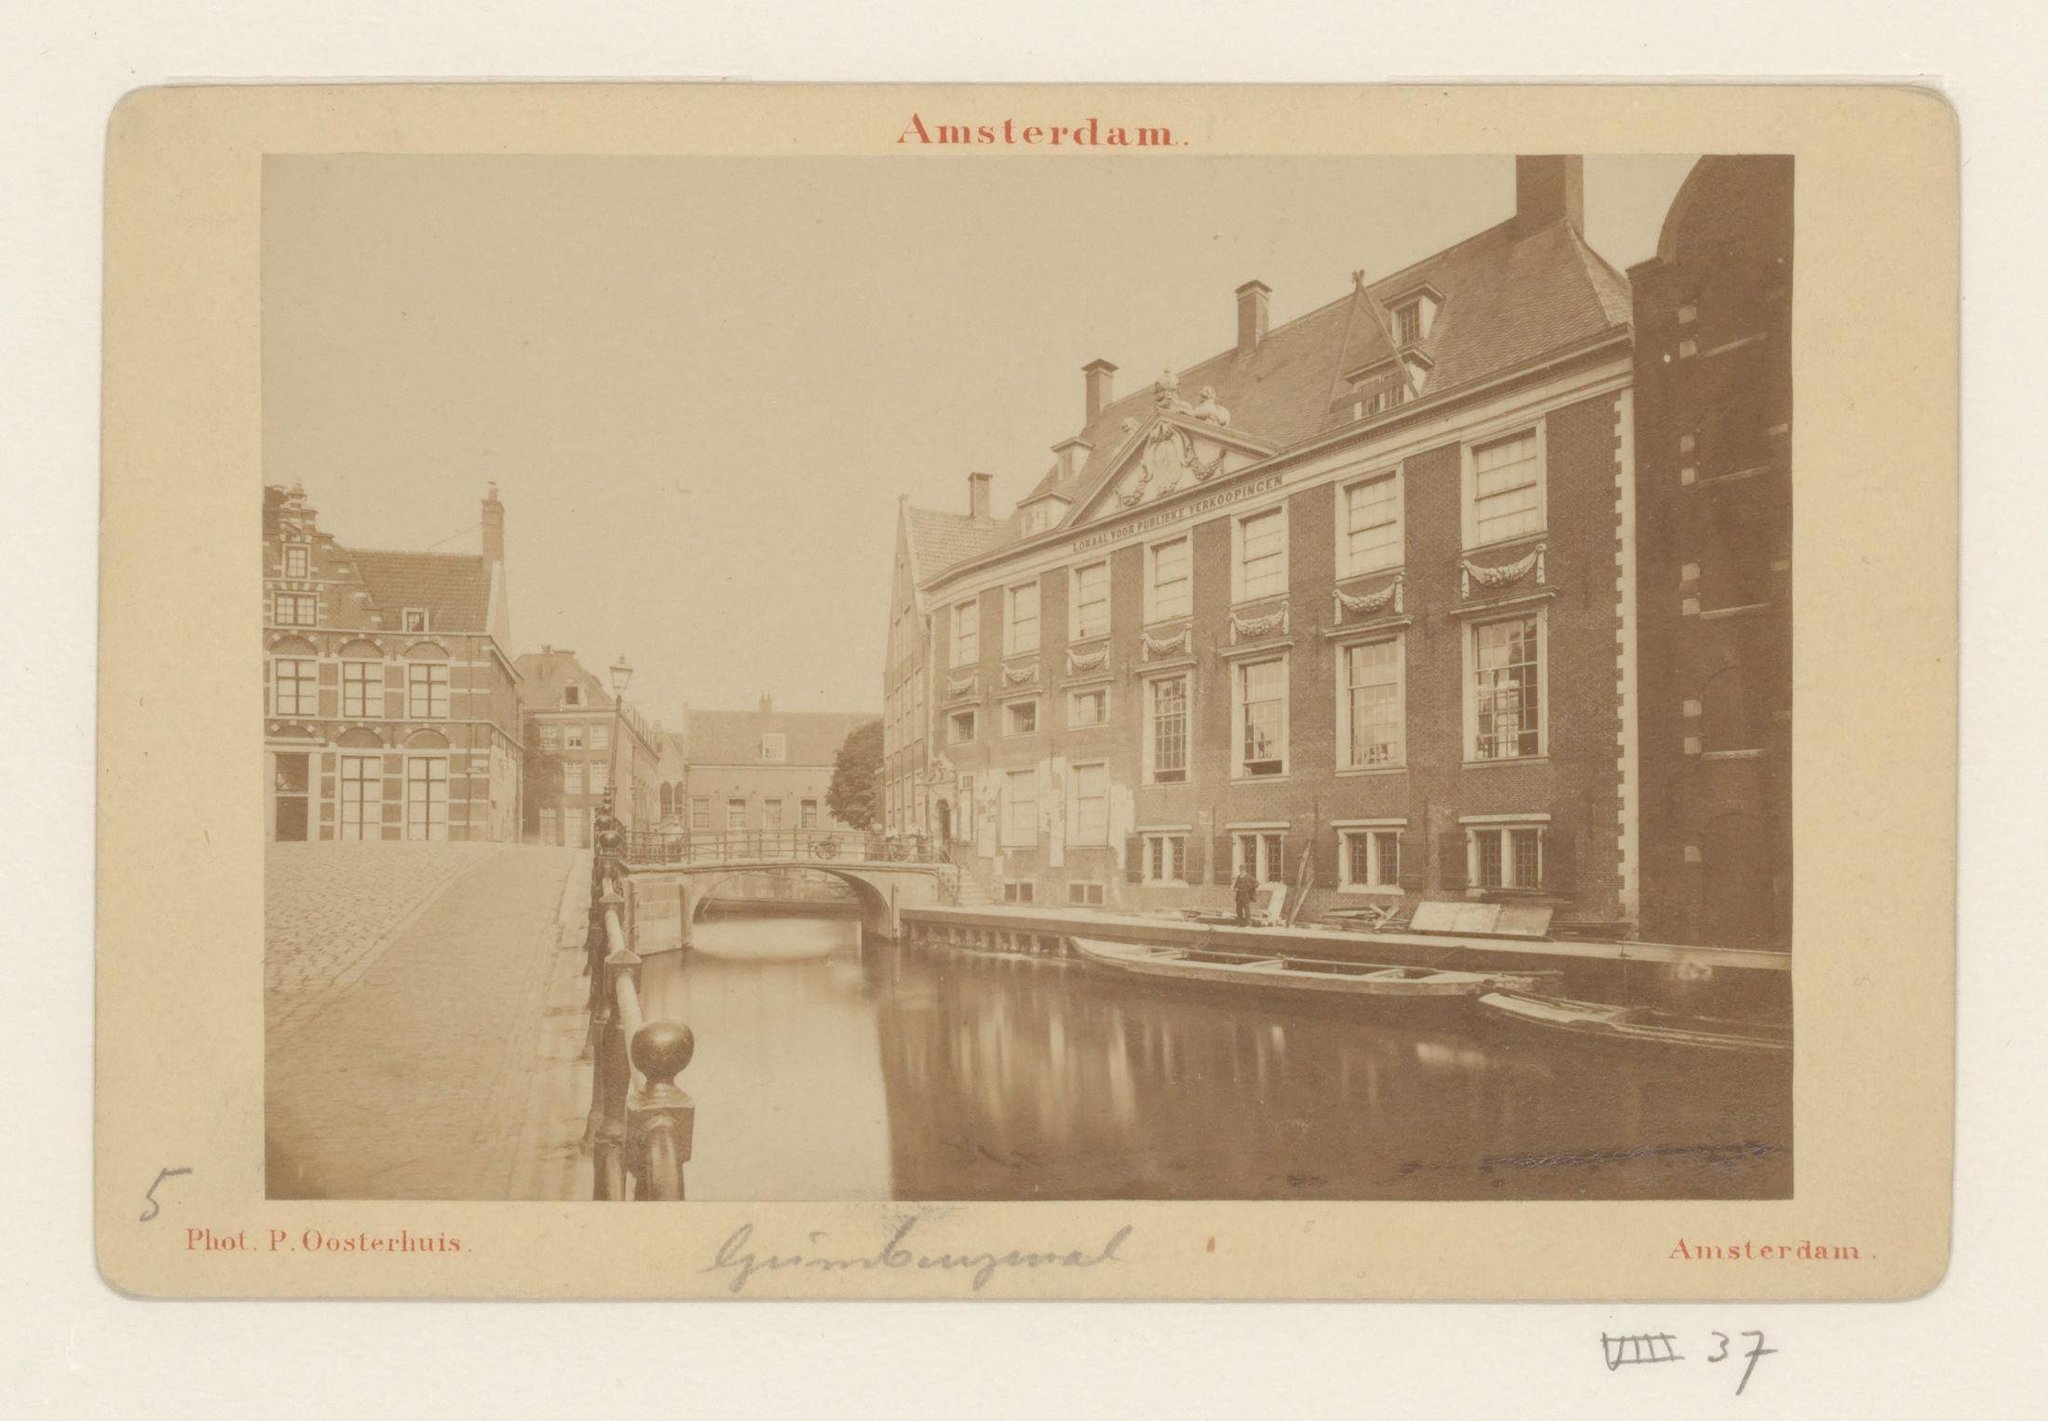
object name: cabinet photograph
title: Gezicht op de Grimburgwal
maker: pieter oosterhuis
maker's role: draughtsman, print maker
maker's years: 1816-1885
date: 1860-1885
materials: cardboard, paper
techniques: albumen print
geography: amsterdam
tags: city-view in general; 'veduta', canal, façade (of house or building)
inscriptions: collector's mark: ‘8’ Lugt 1641b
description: Onderwerpsrubriek binnen de Atlas Amsterdam: Galerij Paleis voor Volksvlijt, Gebed zonder end, Geldersche Kade, Gravenstraat, Grimburgwal, Grimnessesluis, Groeneburgwal.